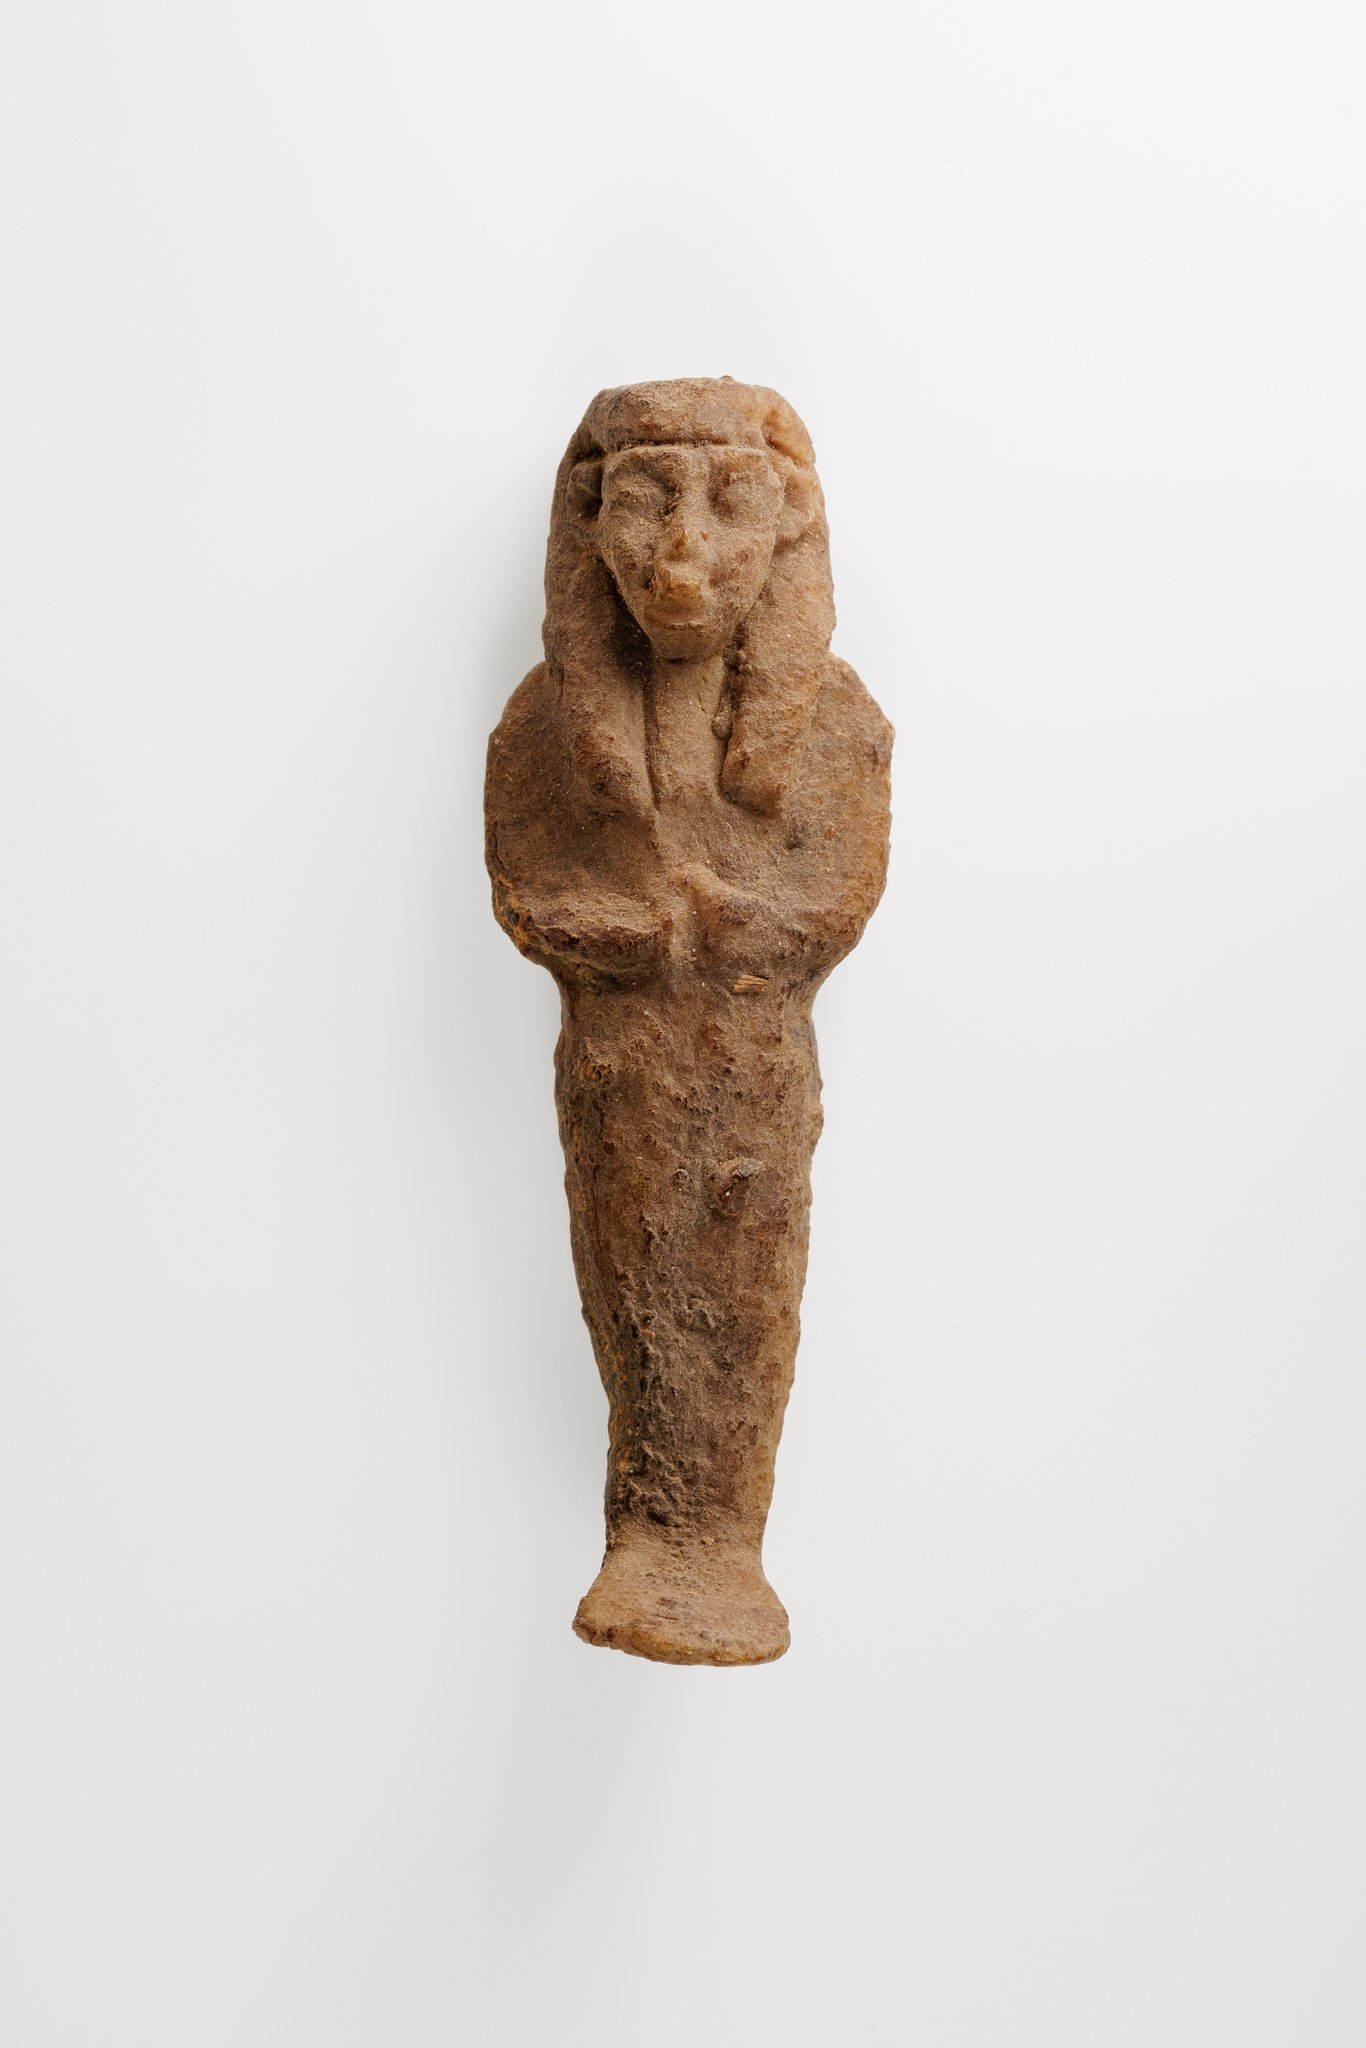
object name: four son of horus, imseti, human headed, nesenaset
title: Viscera figure with human head (Imseti)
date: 1000-945 BCE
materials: wax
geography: egypt